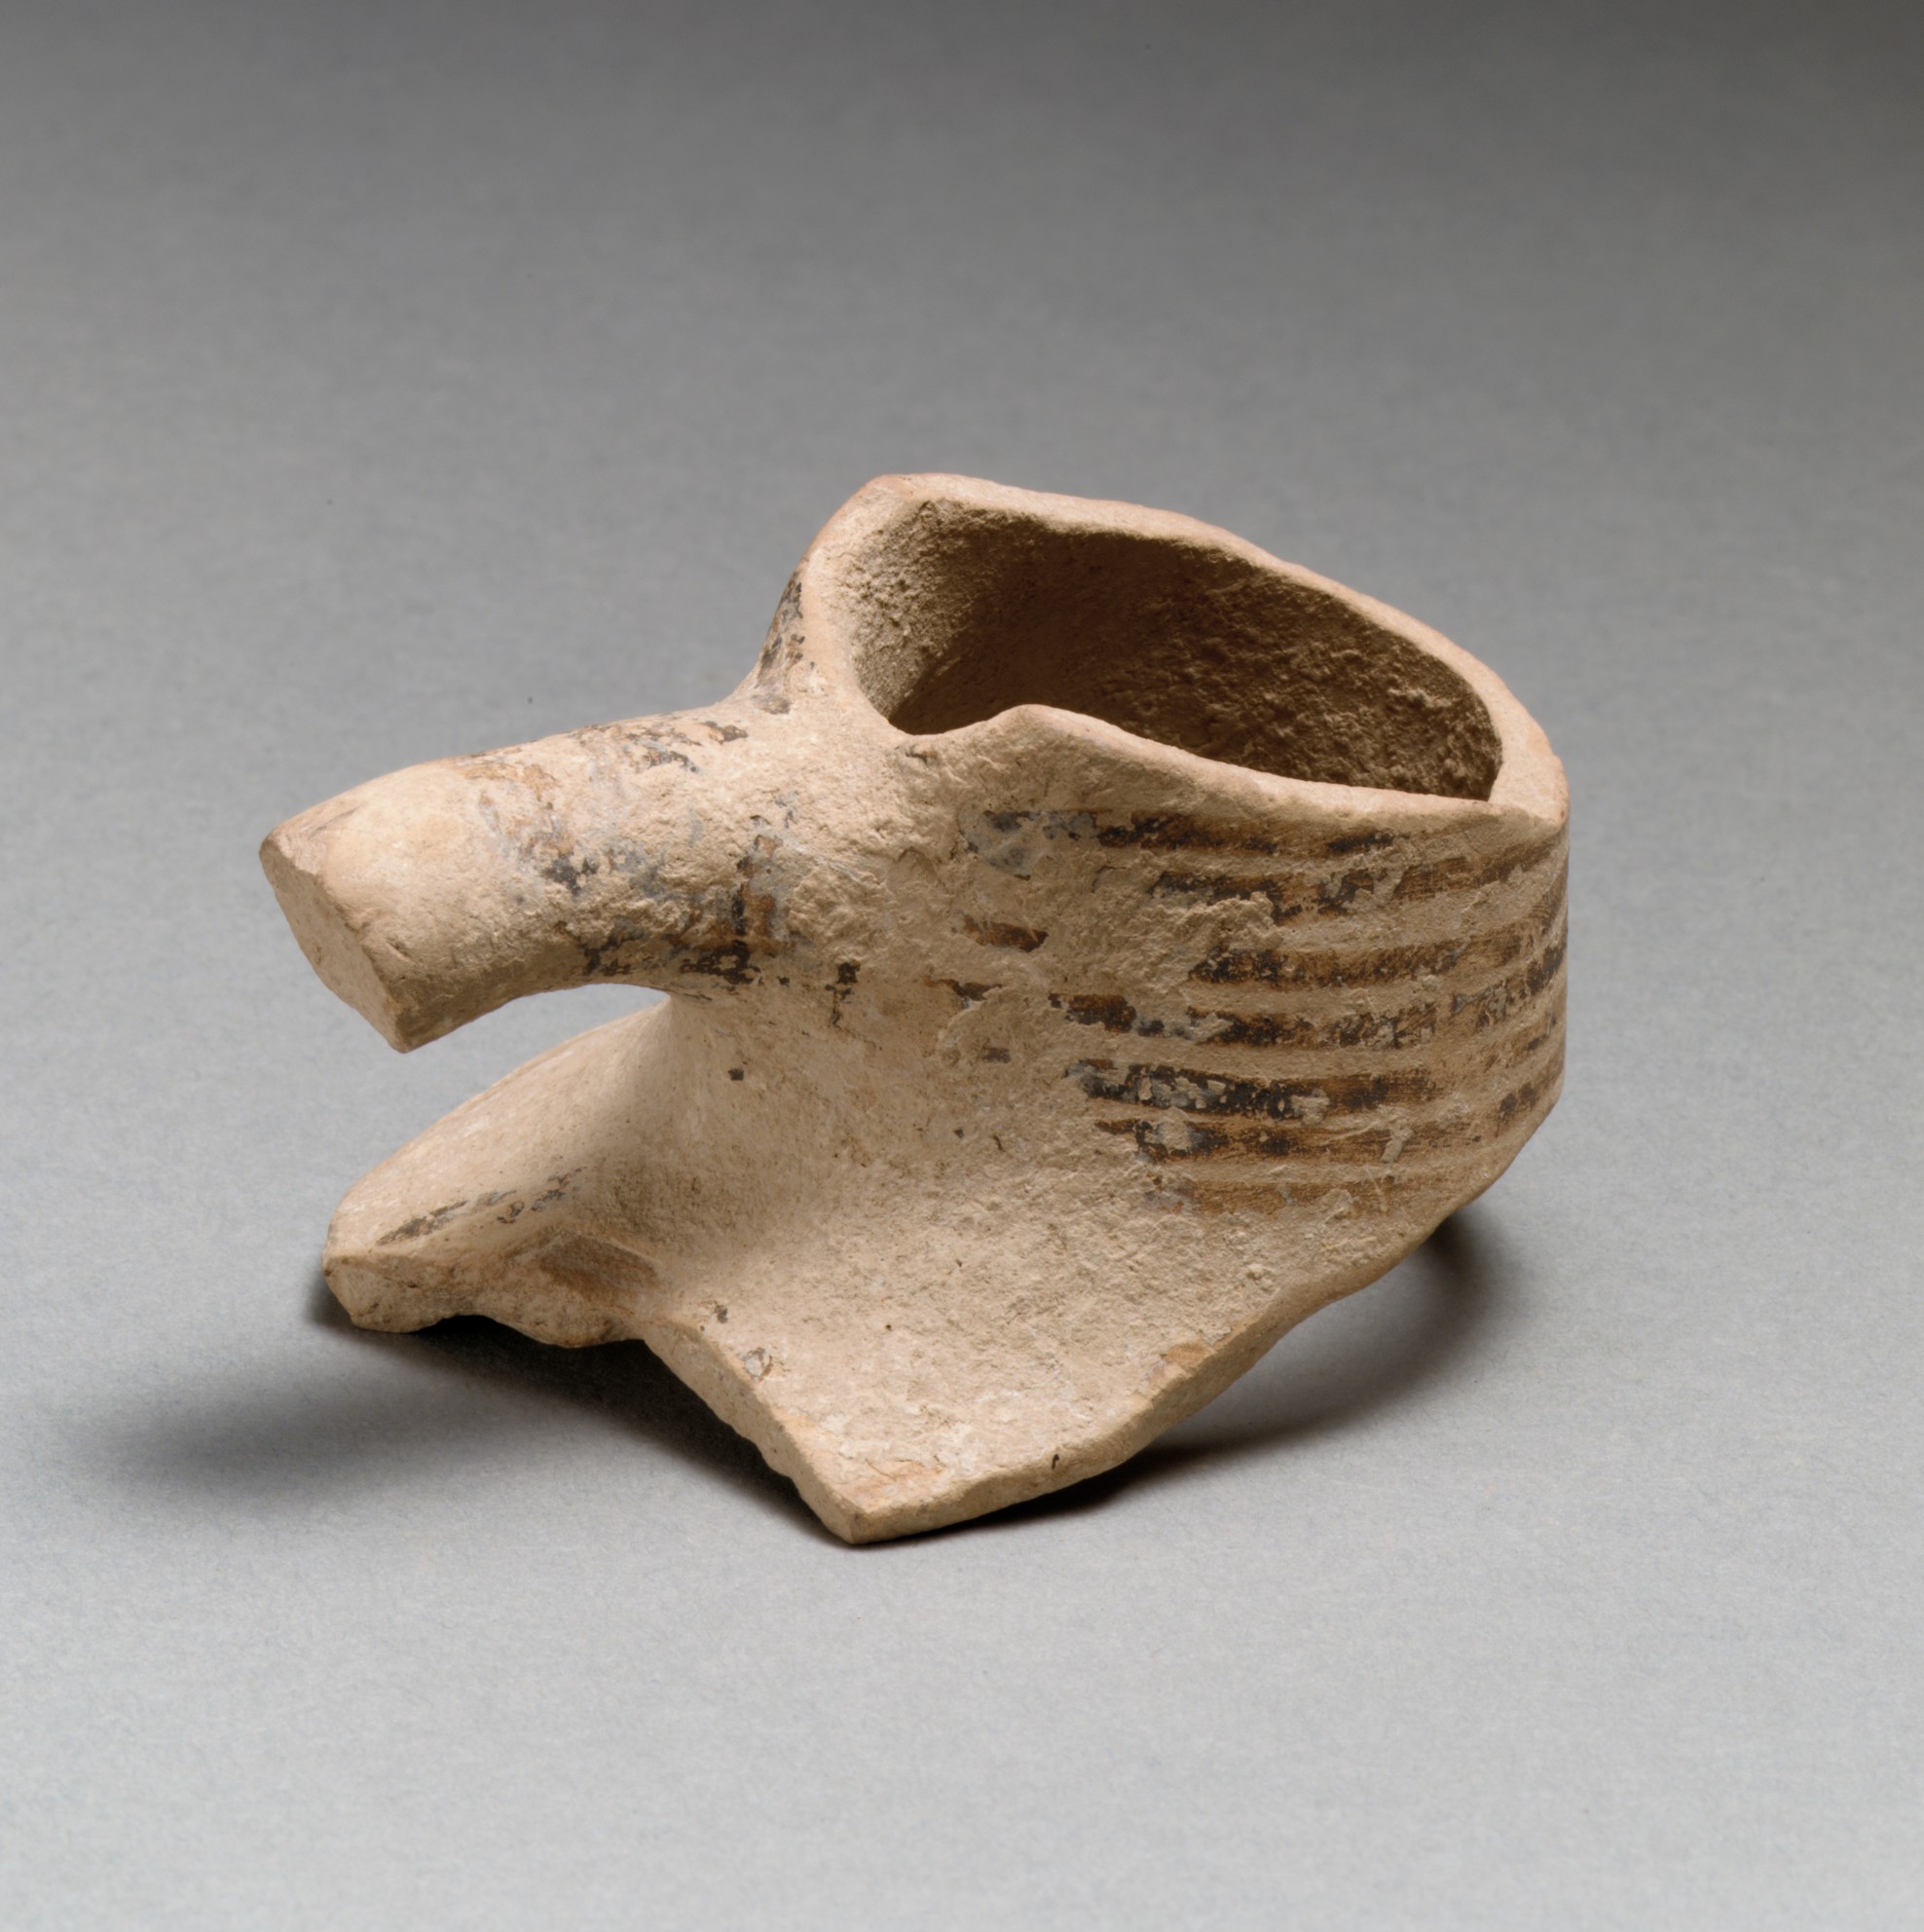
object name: vase fragment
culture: minoan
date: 2600-2000 BCE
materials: terracotta